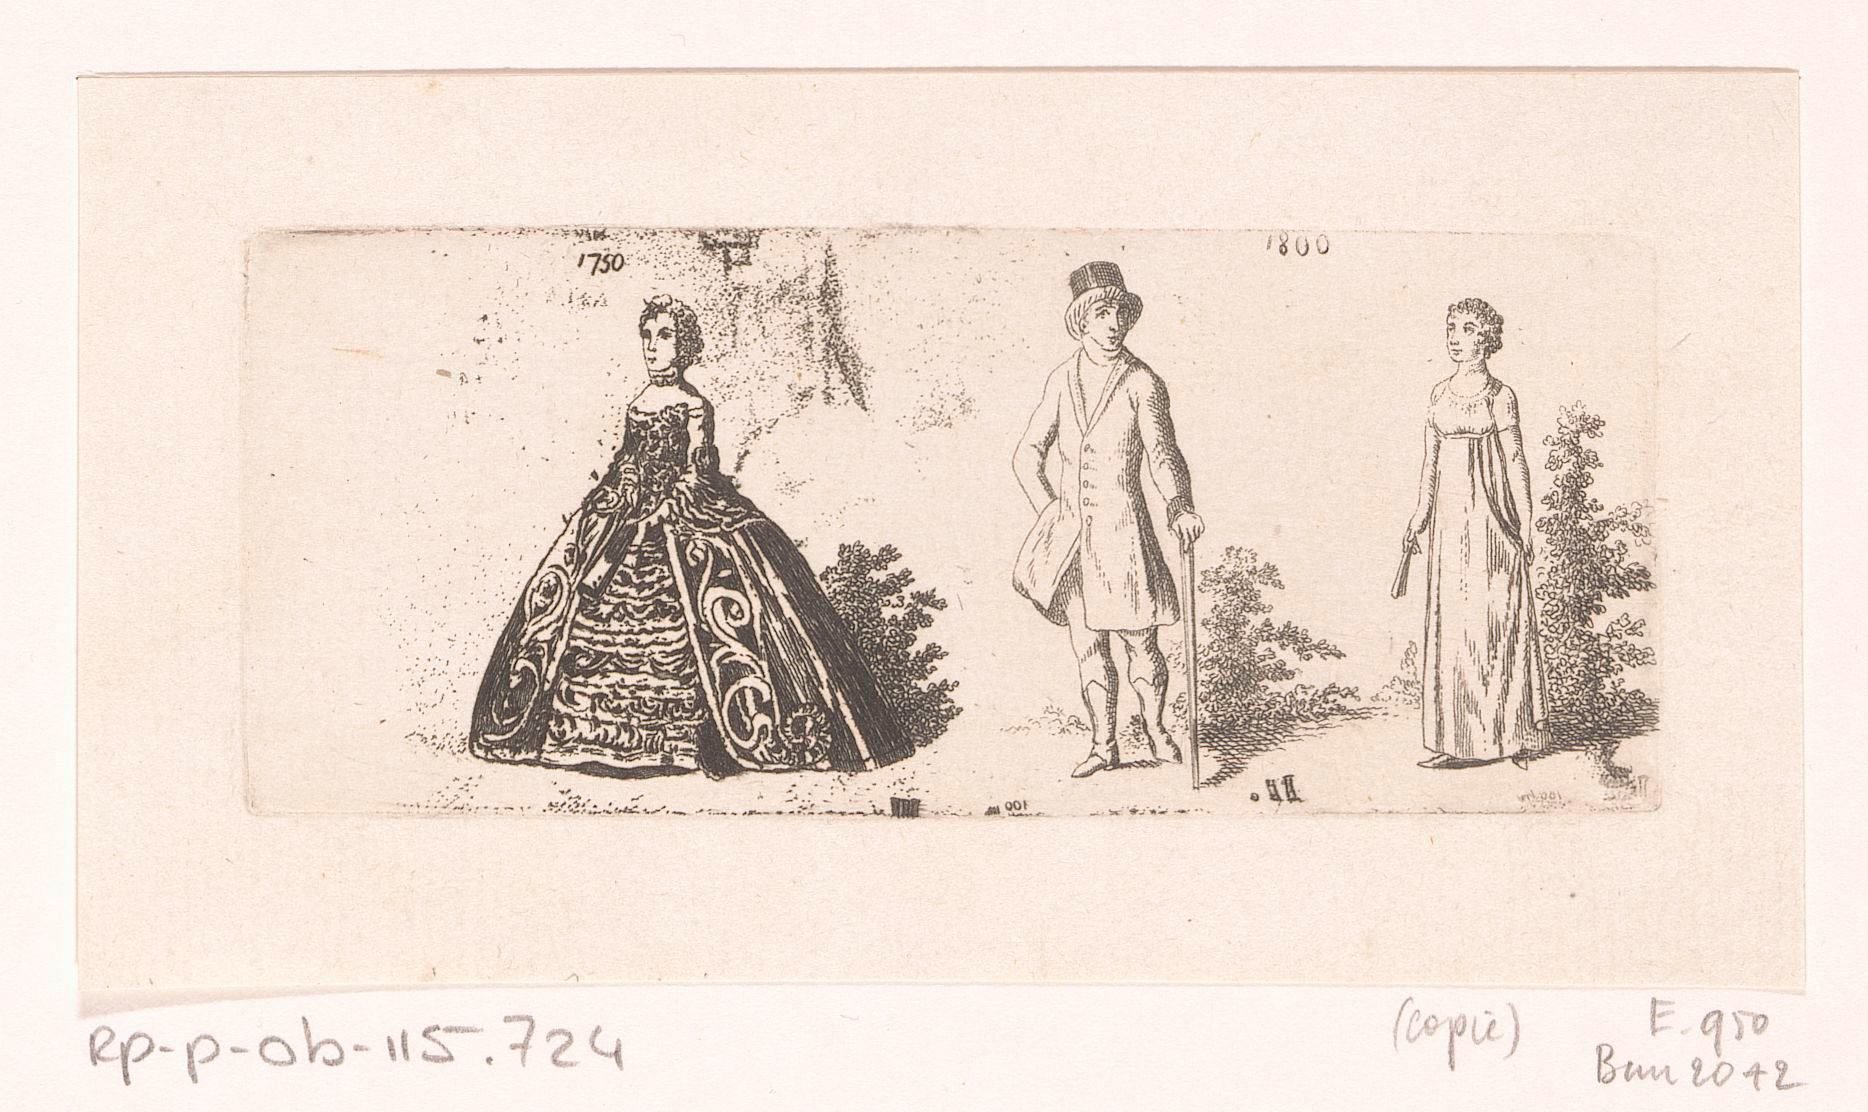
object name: print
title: Drie figuren in mode uit 1750 en 1800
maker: Anonymous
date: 1800-1857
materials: paper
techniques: etching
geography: berlin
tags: fashion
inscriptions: collector's mark: Lugt 2228